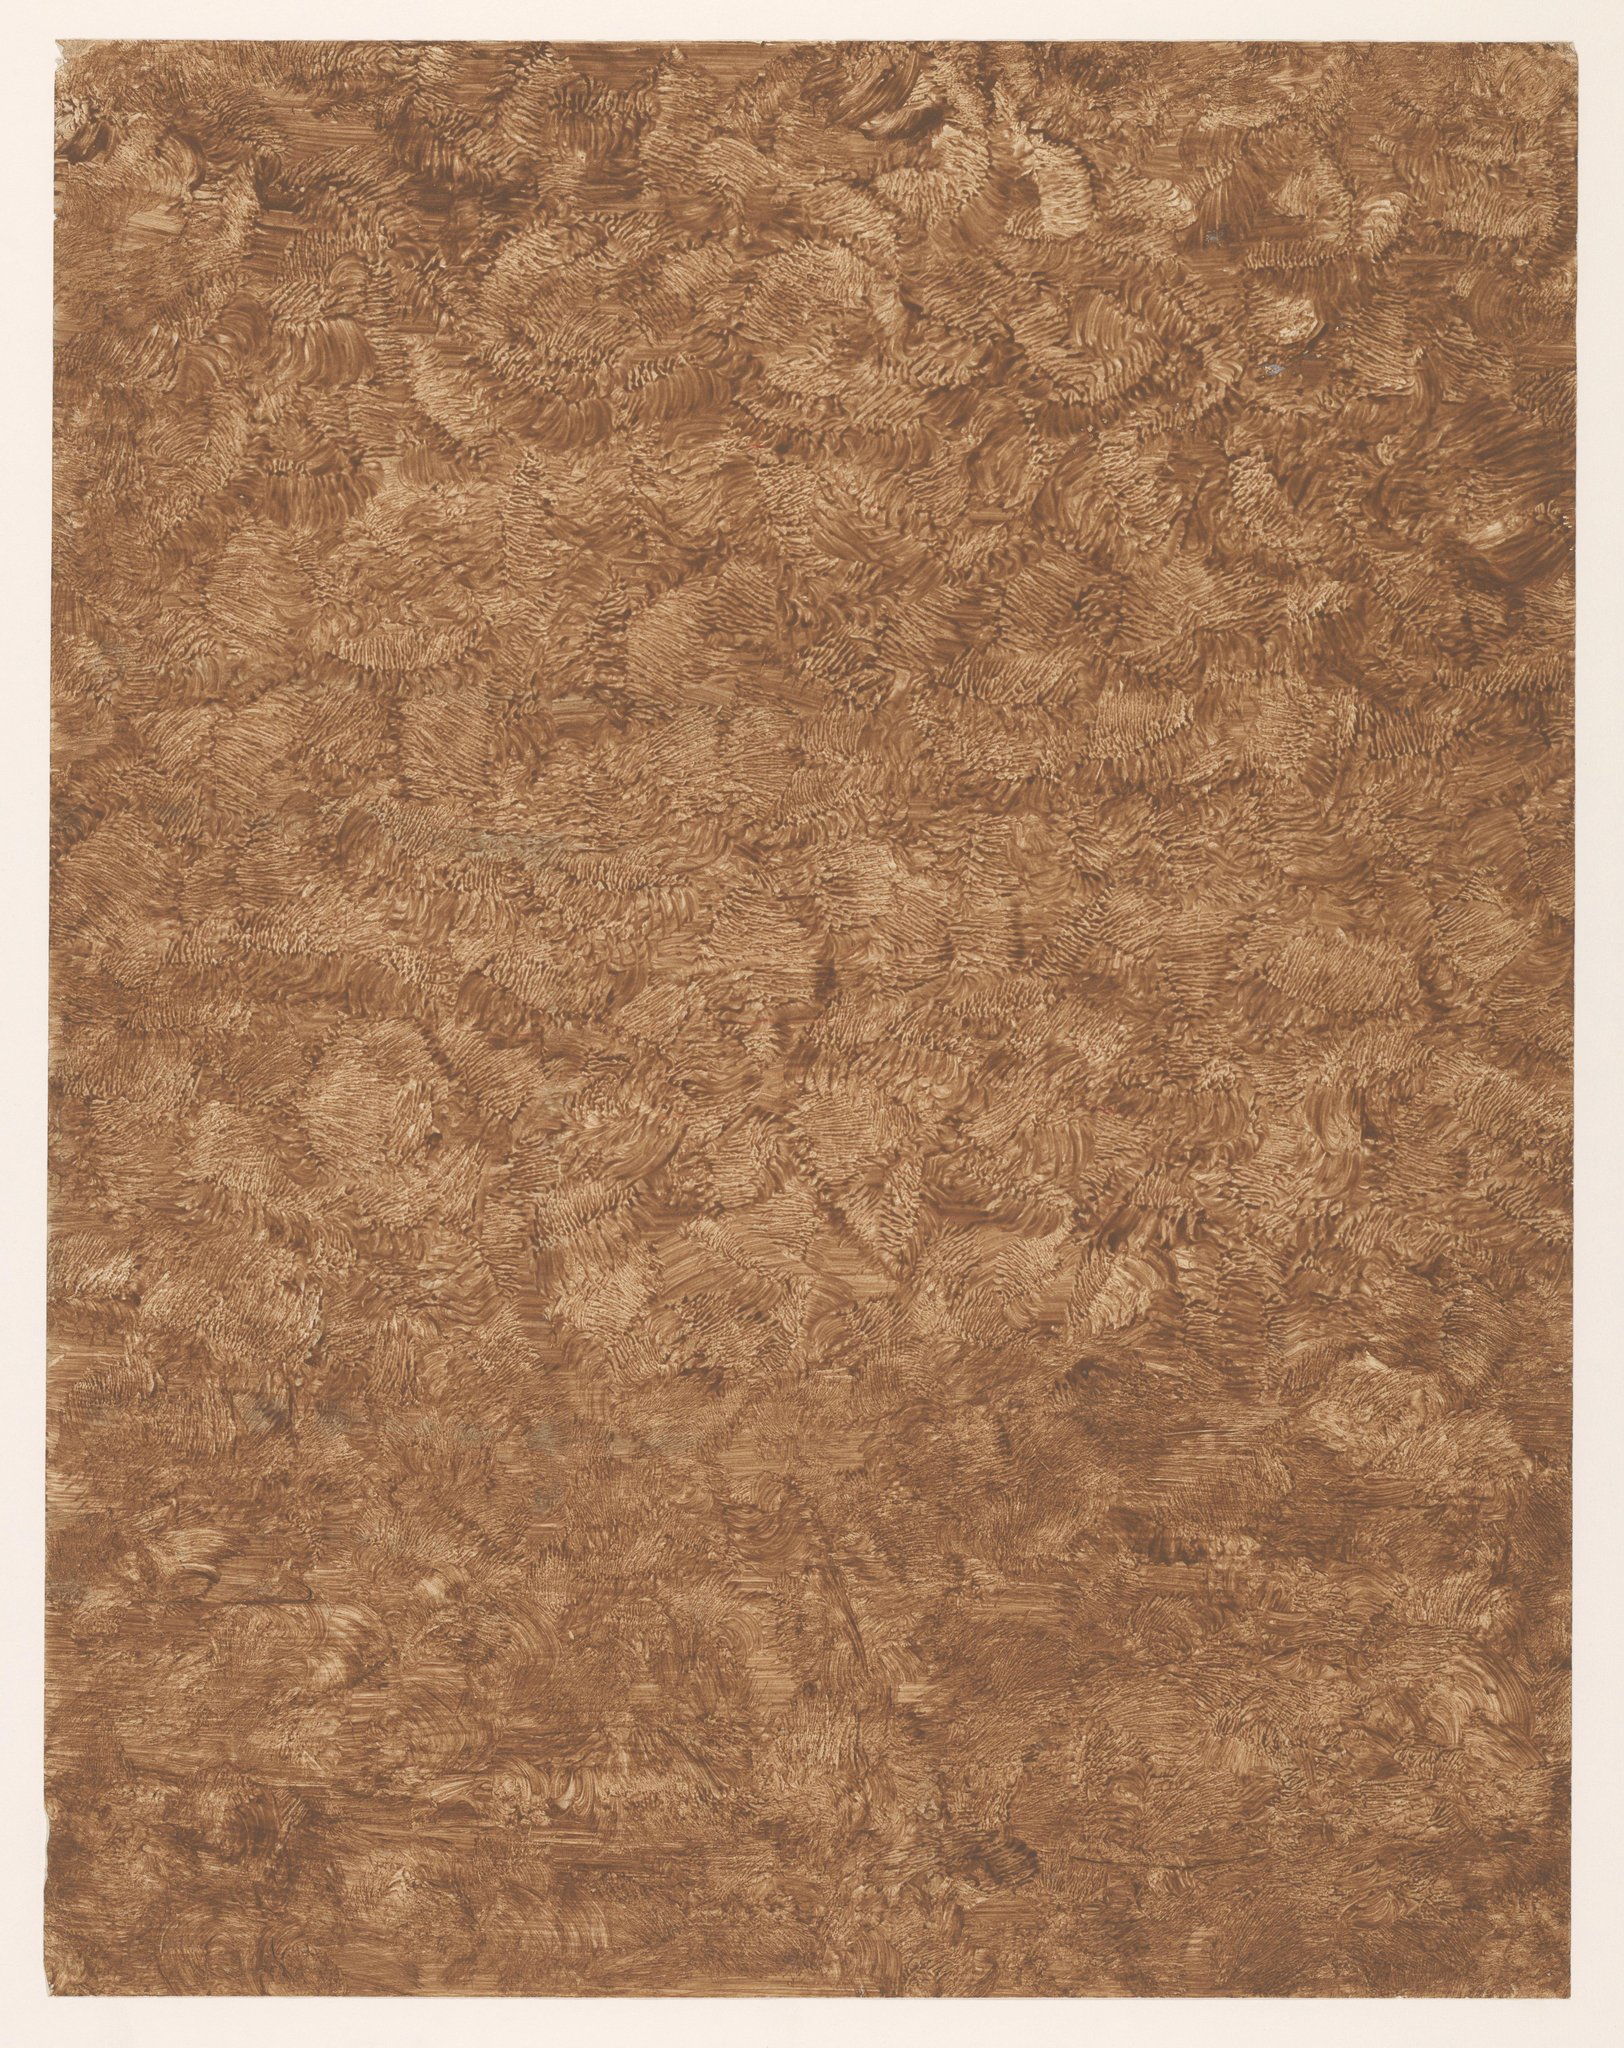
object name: paste paper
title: Stijfselverfpapier in bruin met ingekwaste decoratie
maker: Anonymous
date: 1900-1969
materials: paper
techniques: starch dyeing